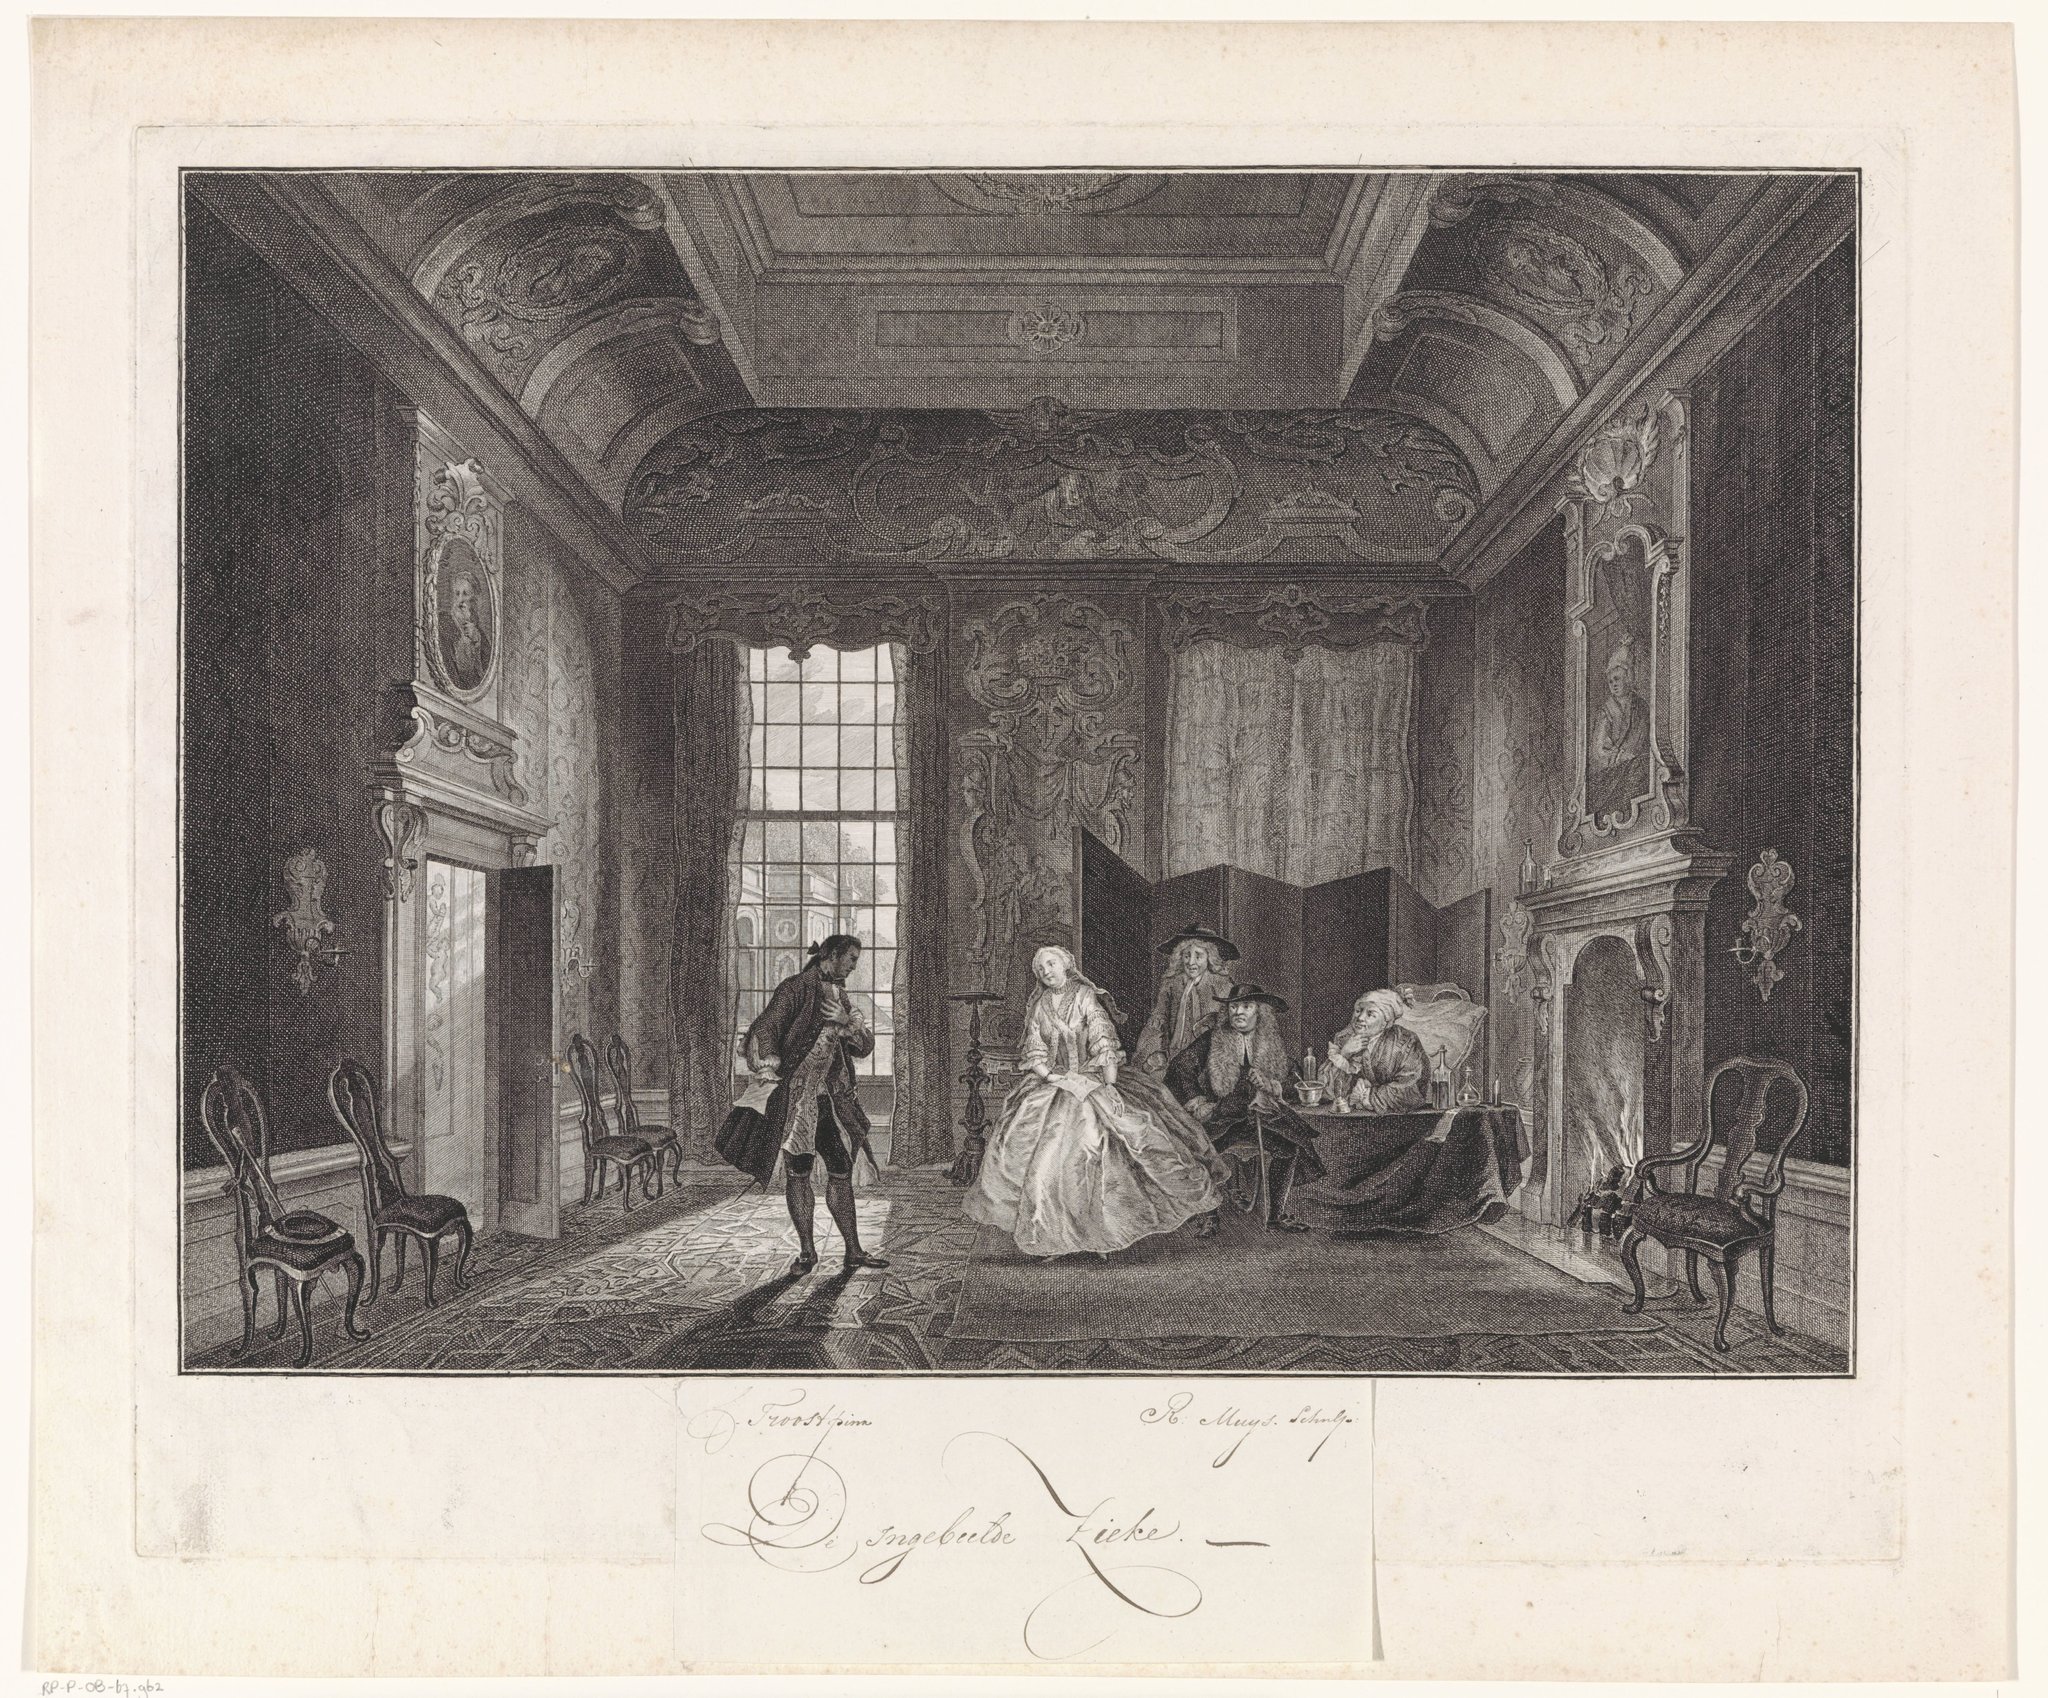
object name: print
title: De ingebeelde zieke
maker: robbert muys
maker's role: print maker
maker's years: 1742-1825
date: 1752-1800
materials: paper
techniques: engraving, etching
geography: rotterdam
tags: hypochondriac, pharmacist, druggist, apothecary; pharmacy, drugstore, dispensing chemist, container of glass: bottle, jar, vase, meeting, living-room, parlour, sitting-room, comedy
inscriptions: inscription: ‘C. Troost pinx / R. Muys schulp. / De Ingebeelde Zieke’, collector's mark: Lugt 2228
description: Helena en haar heimelijke minnaar Ferdinand dragen een herdersdicht aan elkaar voor, waarin de personages elkaar hun liefde betuigen. Aan tafel zitten Helena's vader Manshart (de ingebeelde zieke), en zijn arts Narticoforus. Achter de arts staat zijn zoon Bartrand, voor wie Manshart zijn dochter bestemd heeft. Scène uit het tweede bedrijf van het toneelstuk De ingebeelde zieke van Molière.